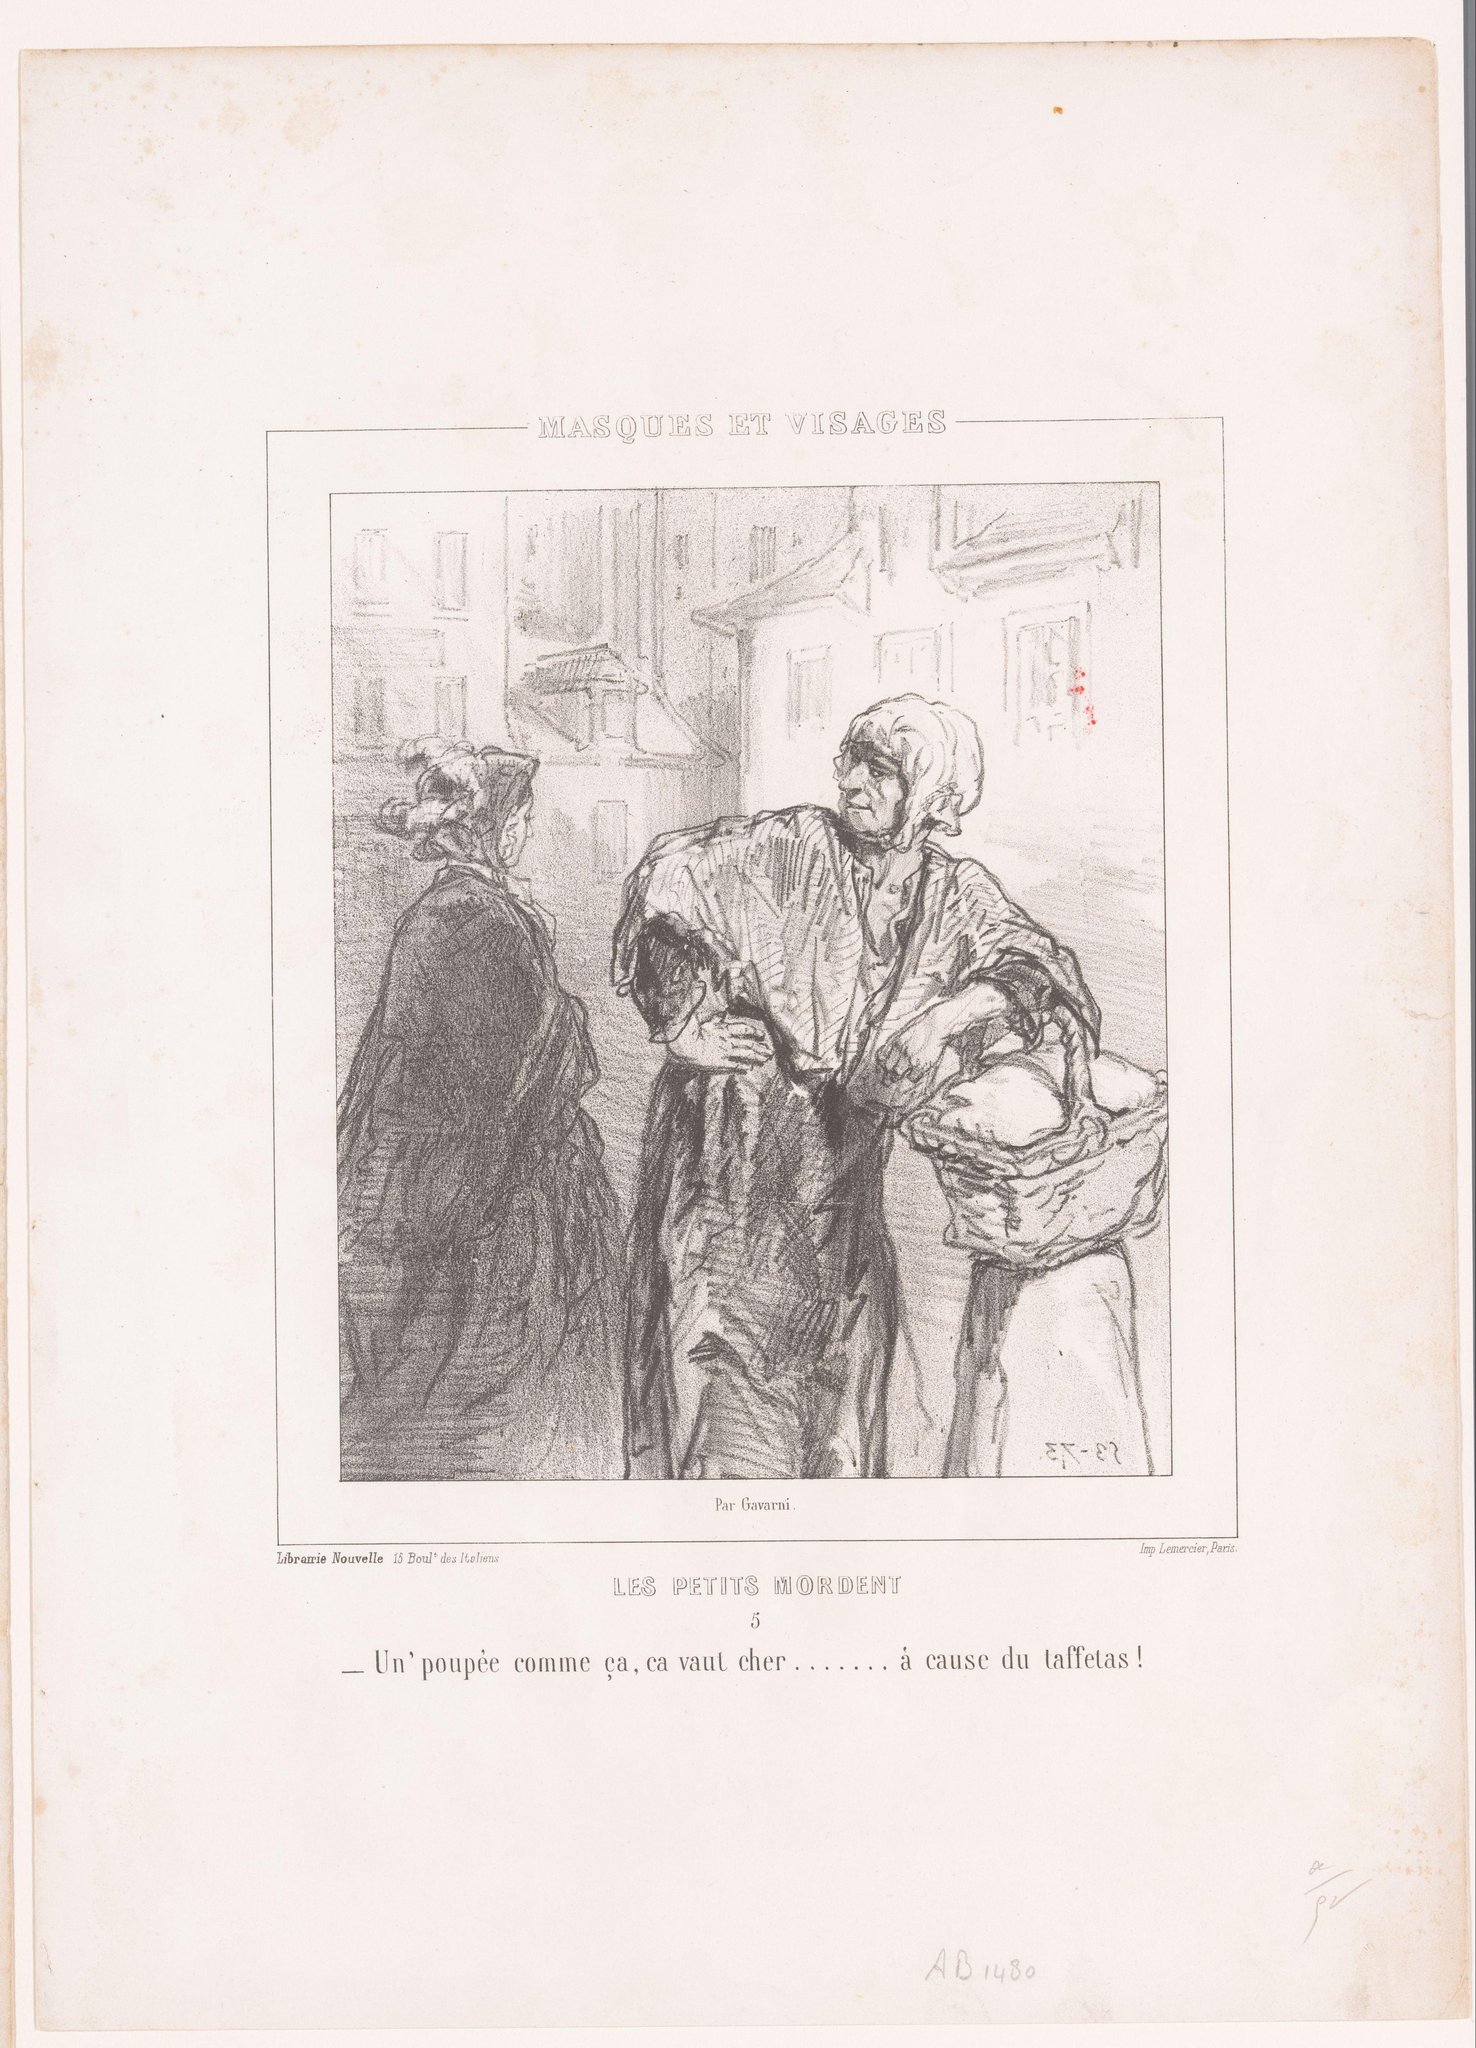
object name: cartoon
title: Oude vrouw bekijkt jonge vrouw op straat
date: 1853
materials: paper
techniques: lithograph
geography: paris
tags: old woman, fashionable woman, 'belle'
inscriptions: collector's mark: Lugt 2228a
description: De vrouw vindt de jonge vrouw vooral de moeite waard vanwege de mooie stof die ze draagt (tafzijde).